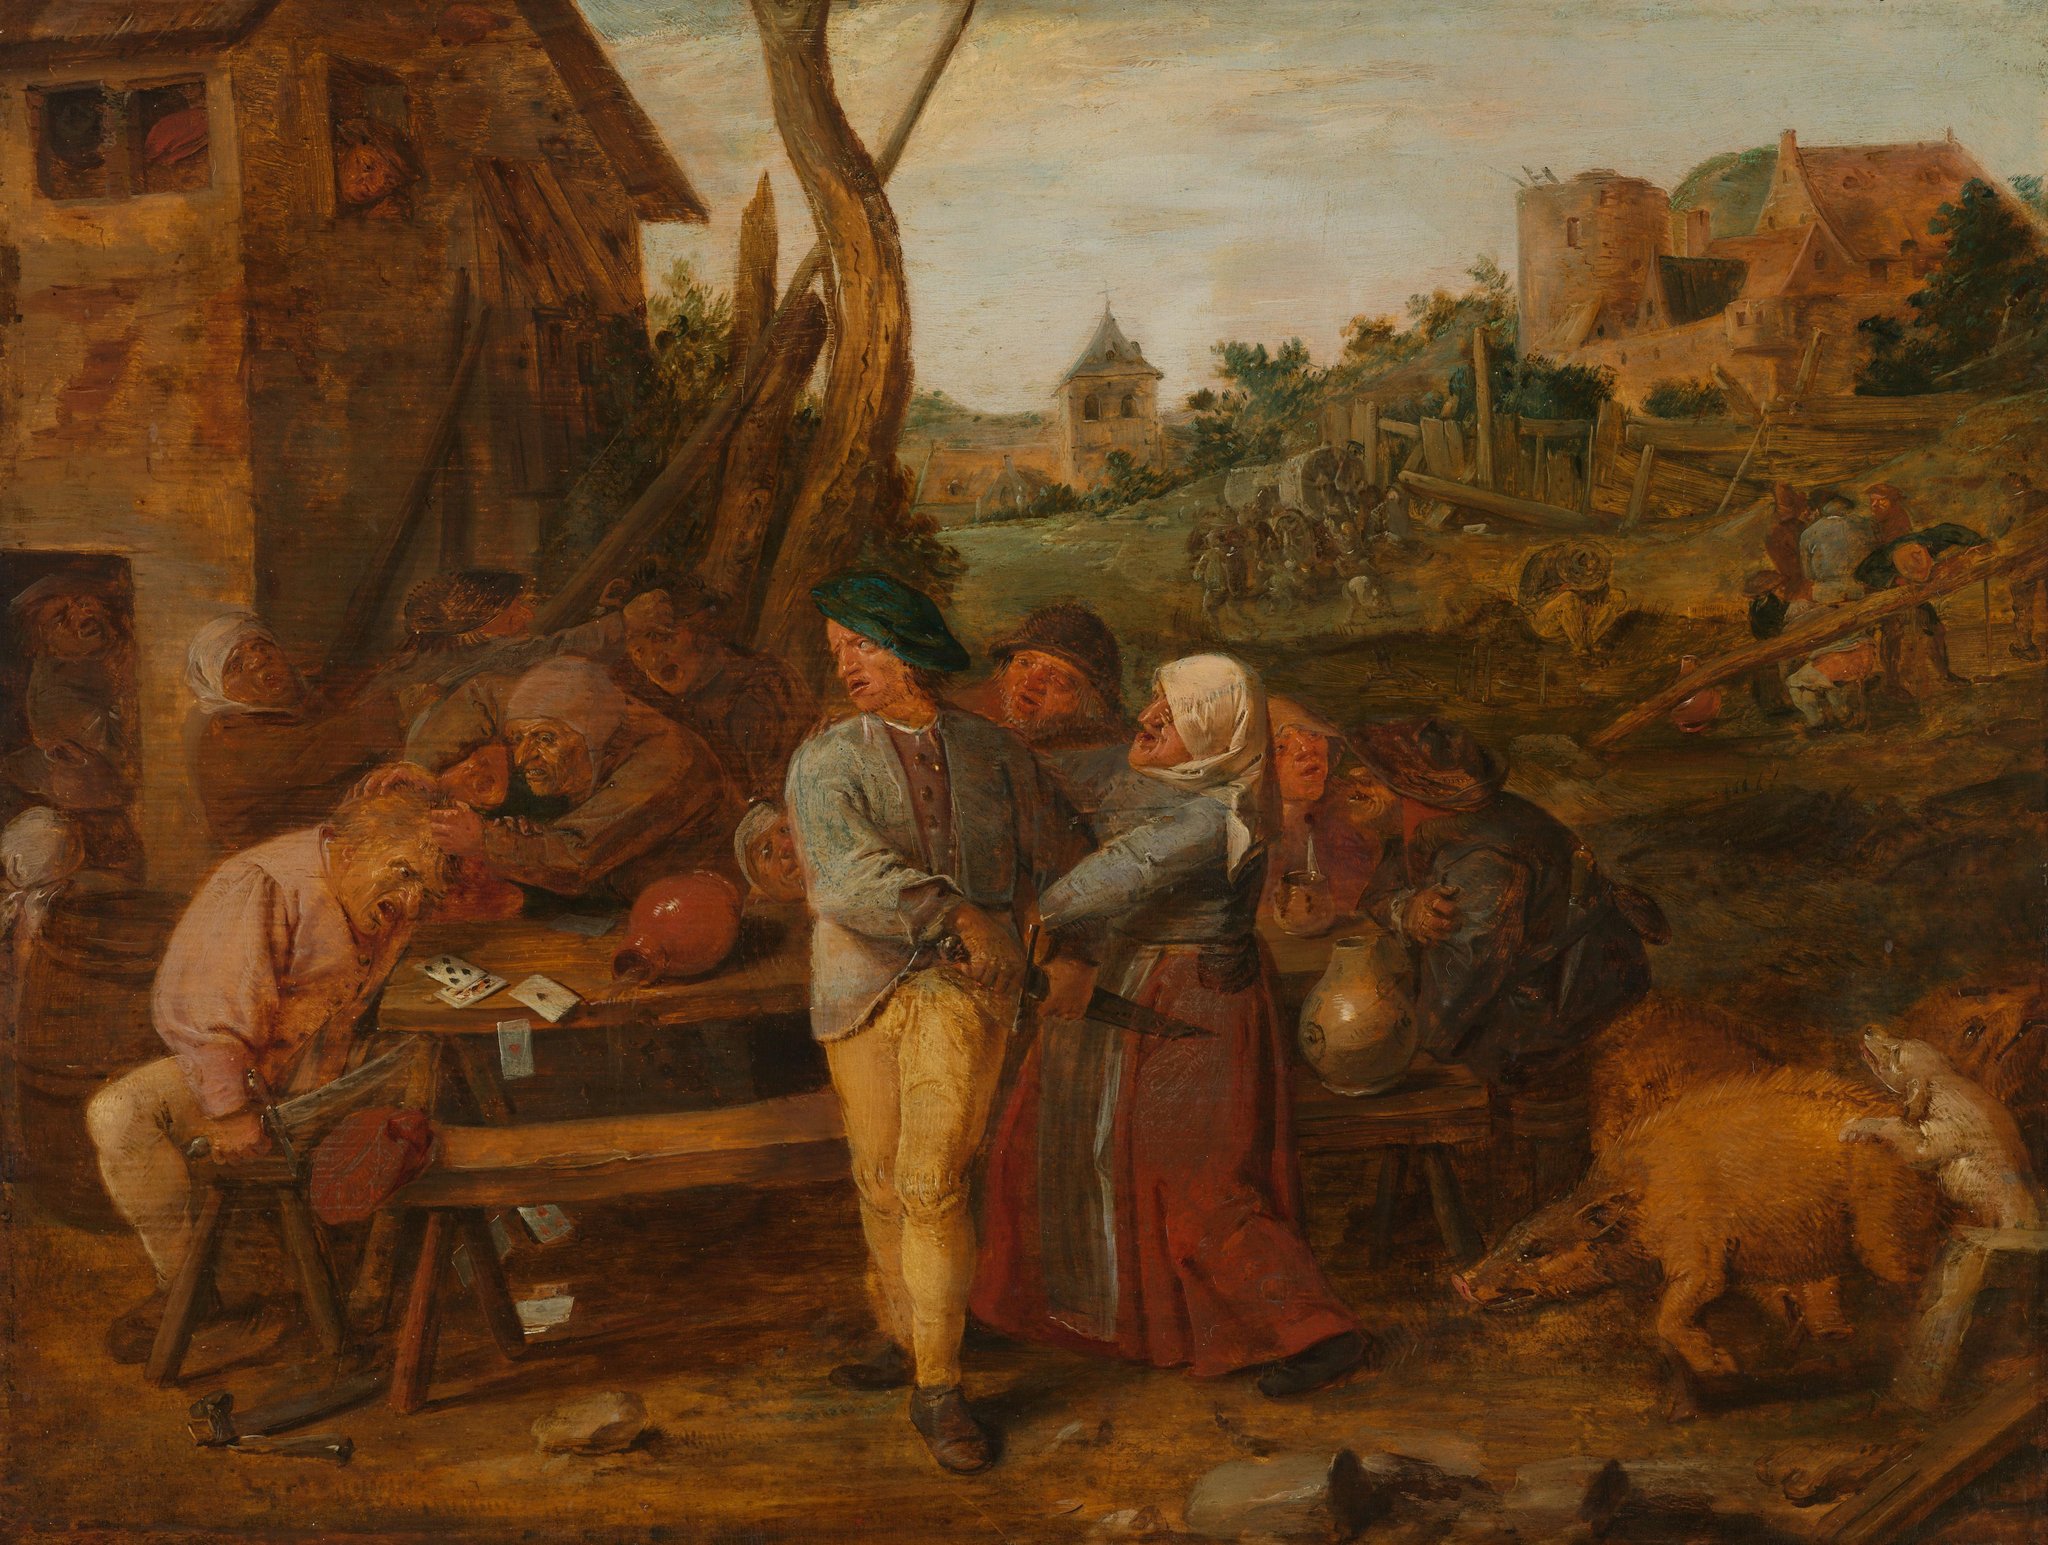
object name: painting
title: Card Fight outside a Country Tavern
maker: adriaen brouwer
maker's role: draughtsman, painter, print maker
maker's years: 1605-1638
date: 1628-1630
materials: oil, paint, panel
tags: card games, pavement, terrace in front of inn or restaurant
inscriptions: inscription, indistinct (remnant of a monogram), bottom right: ‘B’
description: Boerenvechtpartij. Ruzie tussen kaartspelende dronken boeren aan een tafel buiten een herberg. Twee boeren trekken zwaarden, vrouwen proberen ze tegen te houden. Rechts varkens in de modder.